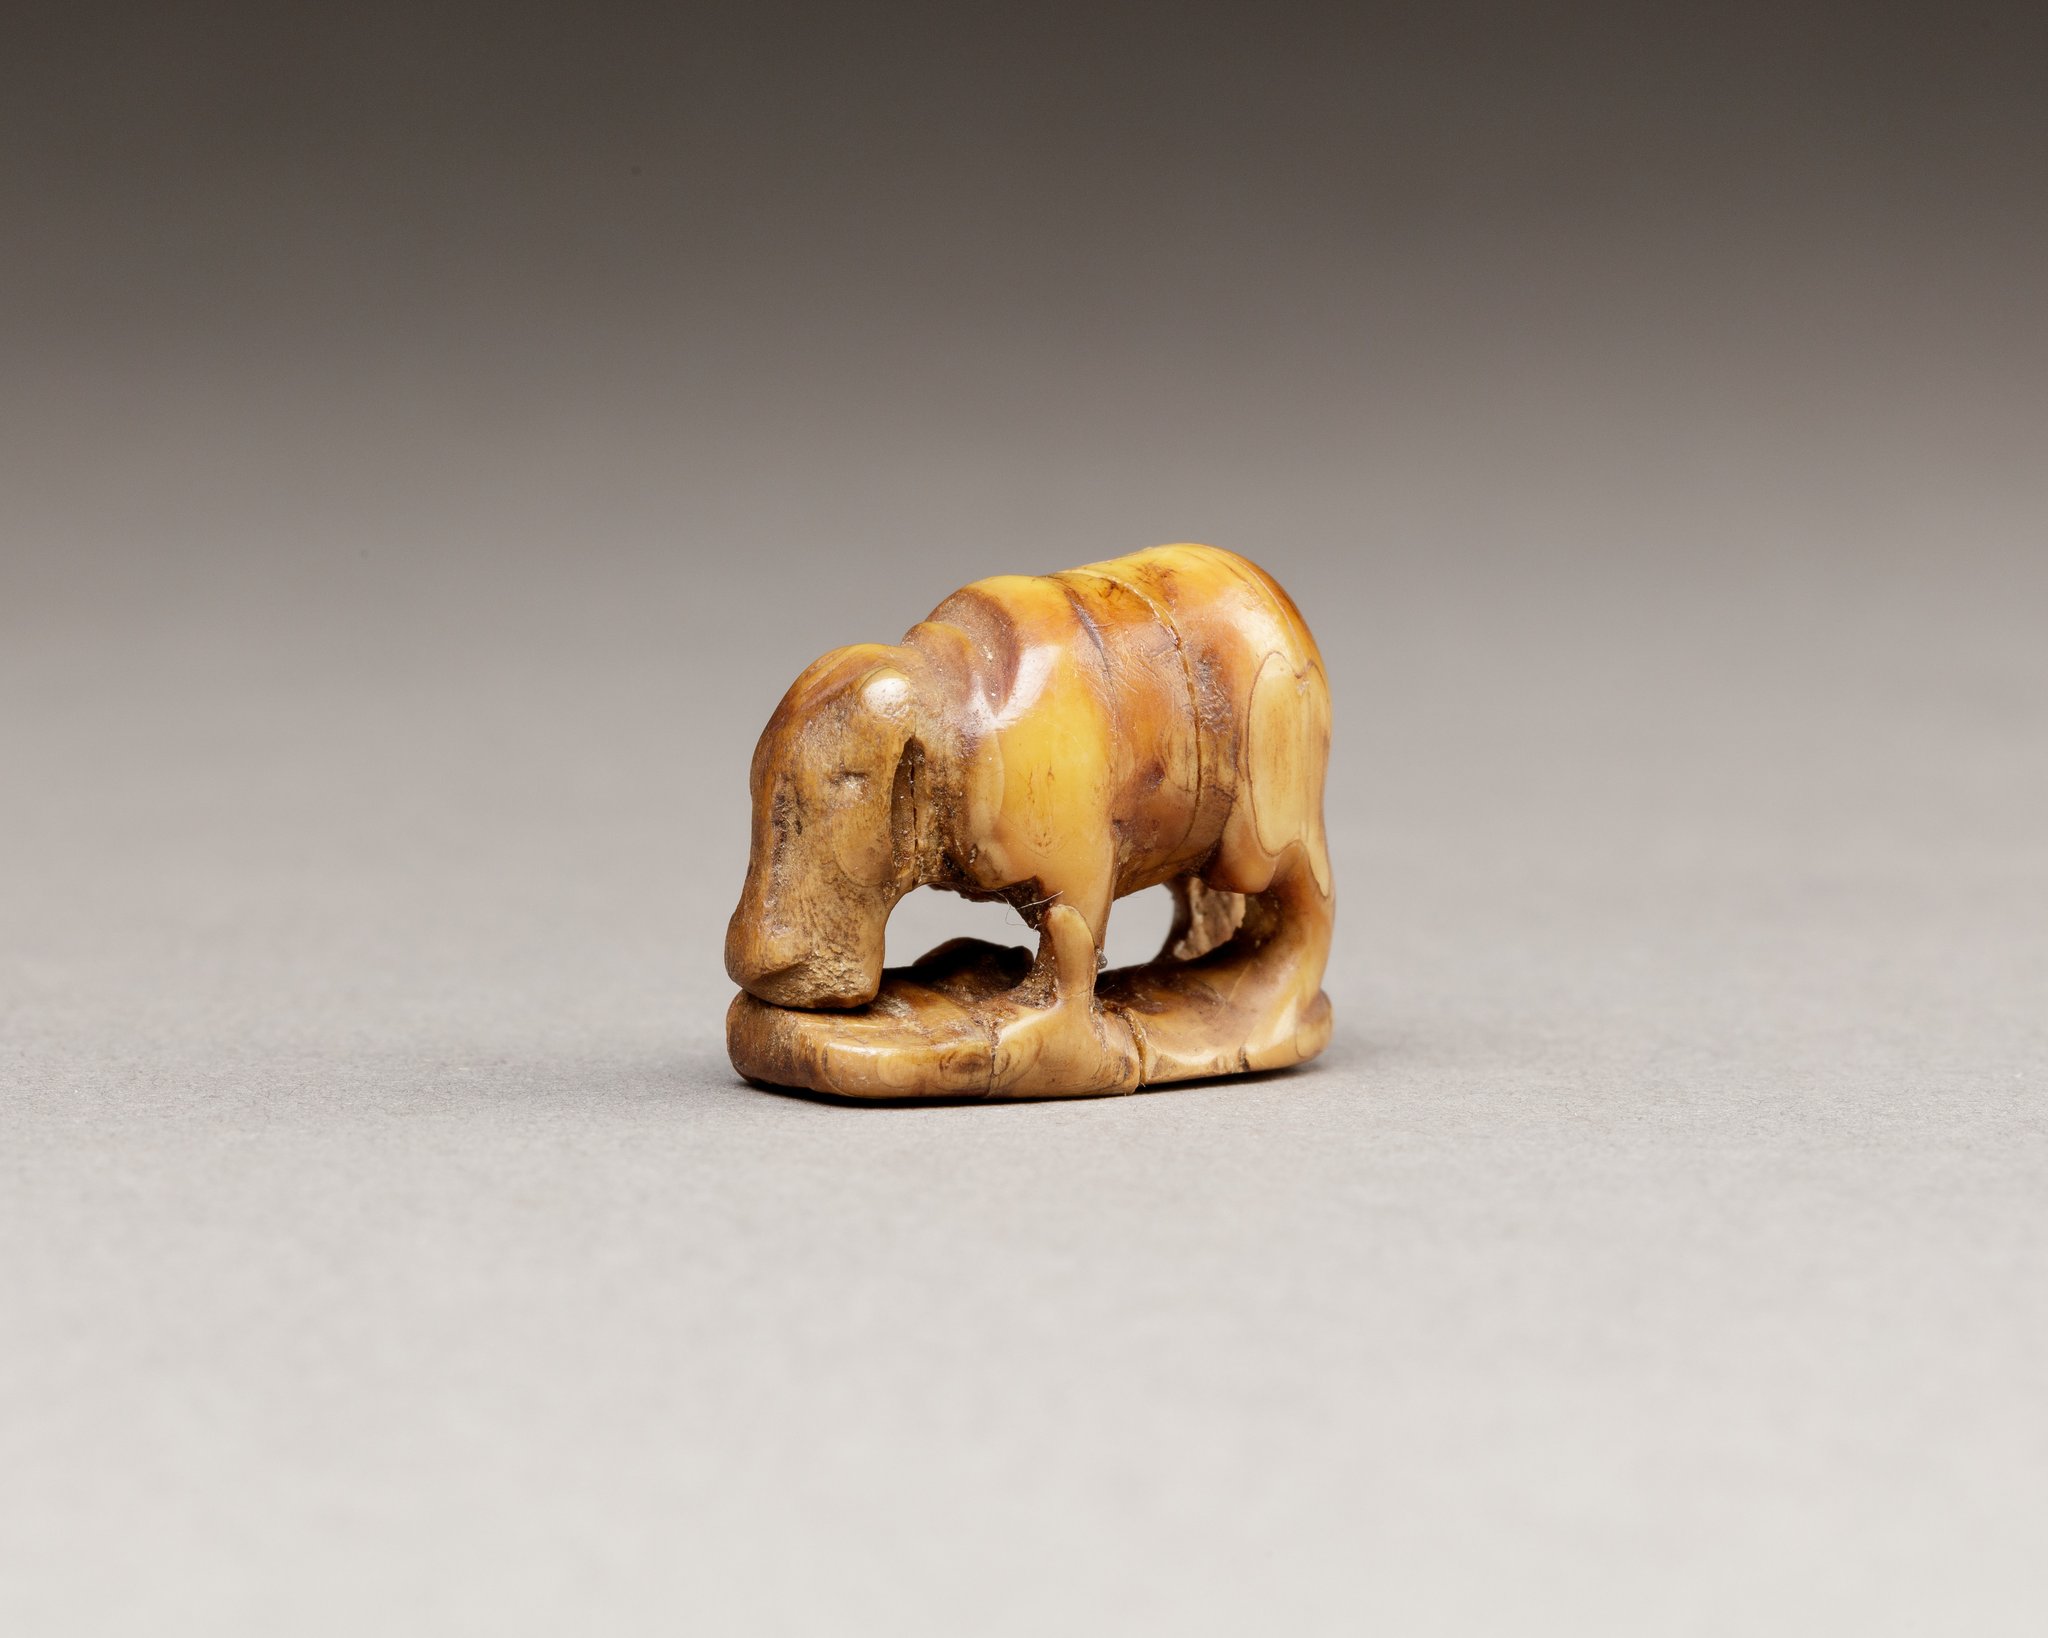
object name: figurine, hippopotamus, sled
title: Figurine or amulet of a hippo on a sled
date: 2960-2649 BCE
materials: ivory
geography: egypt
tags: hippos